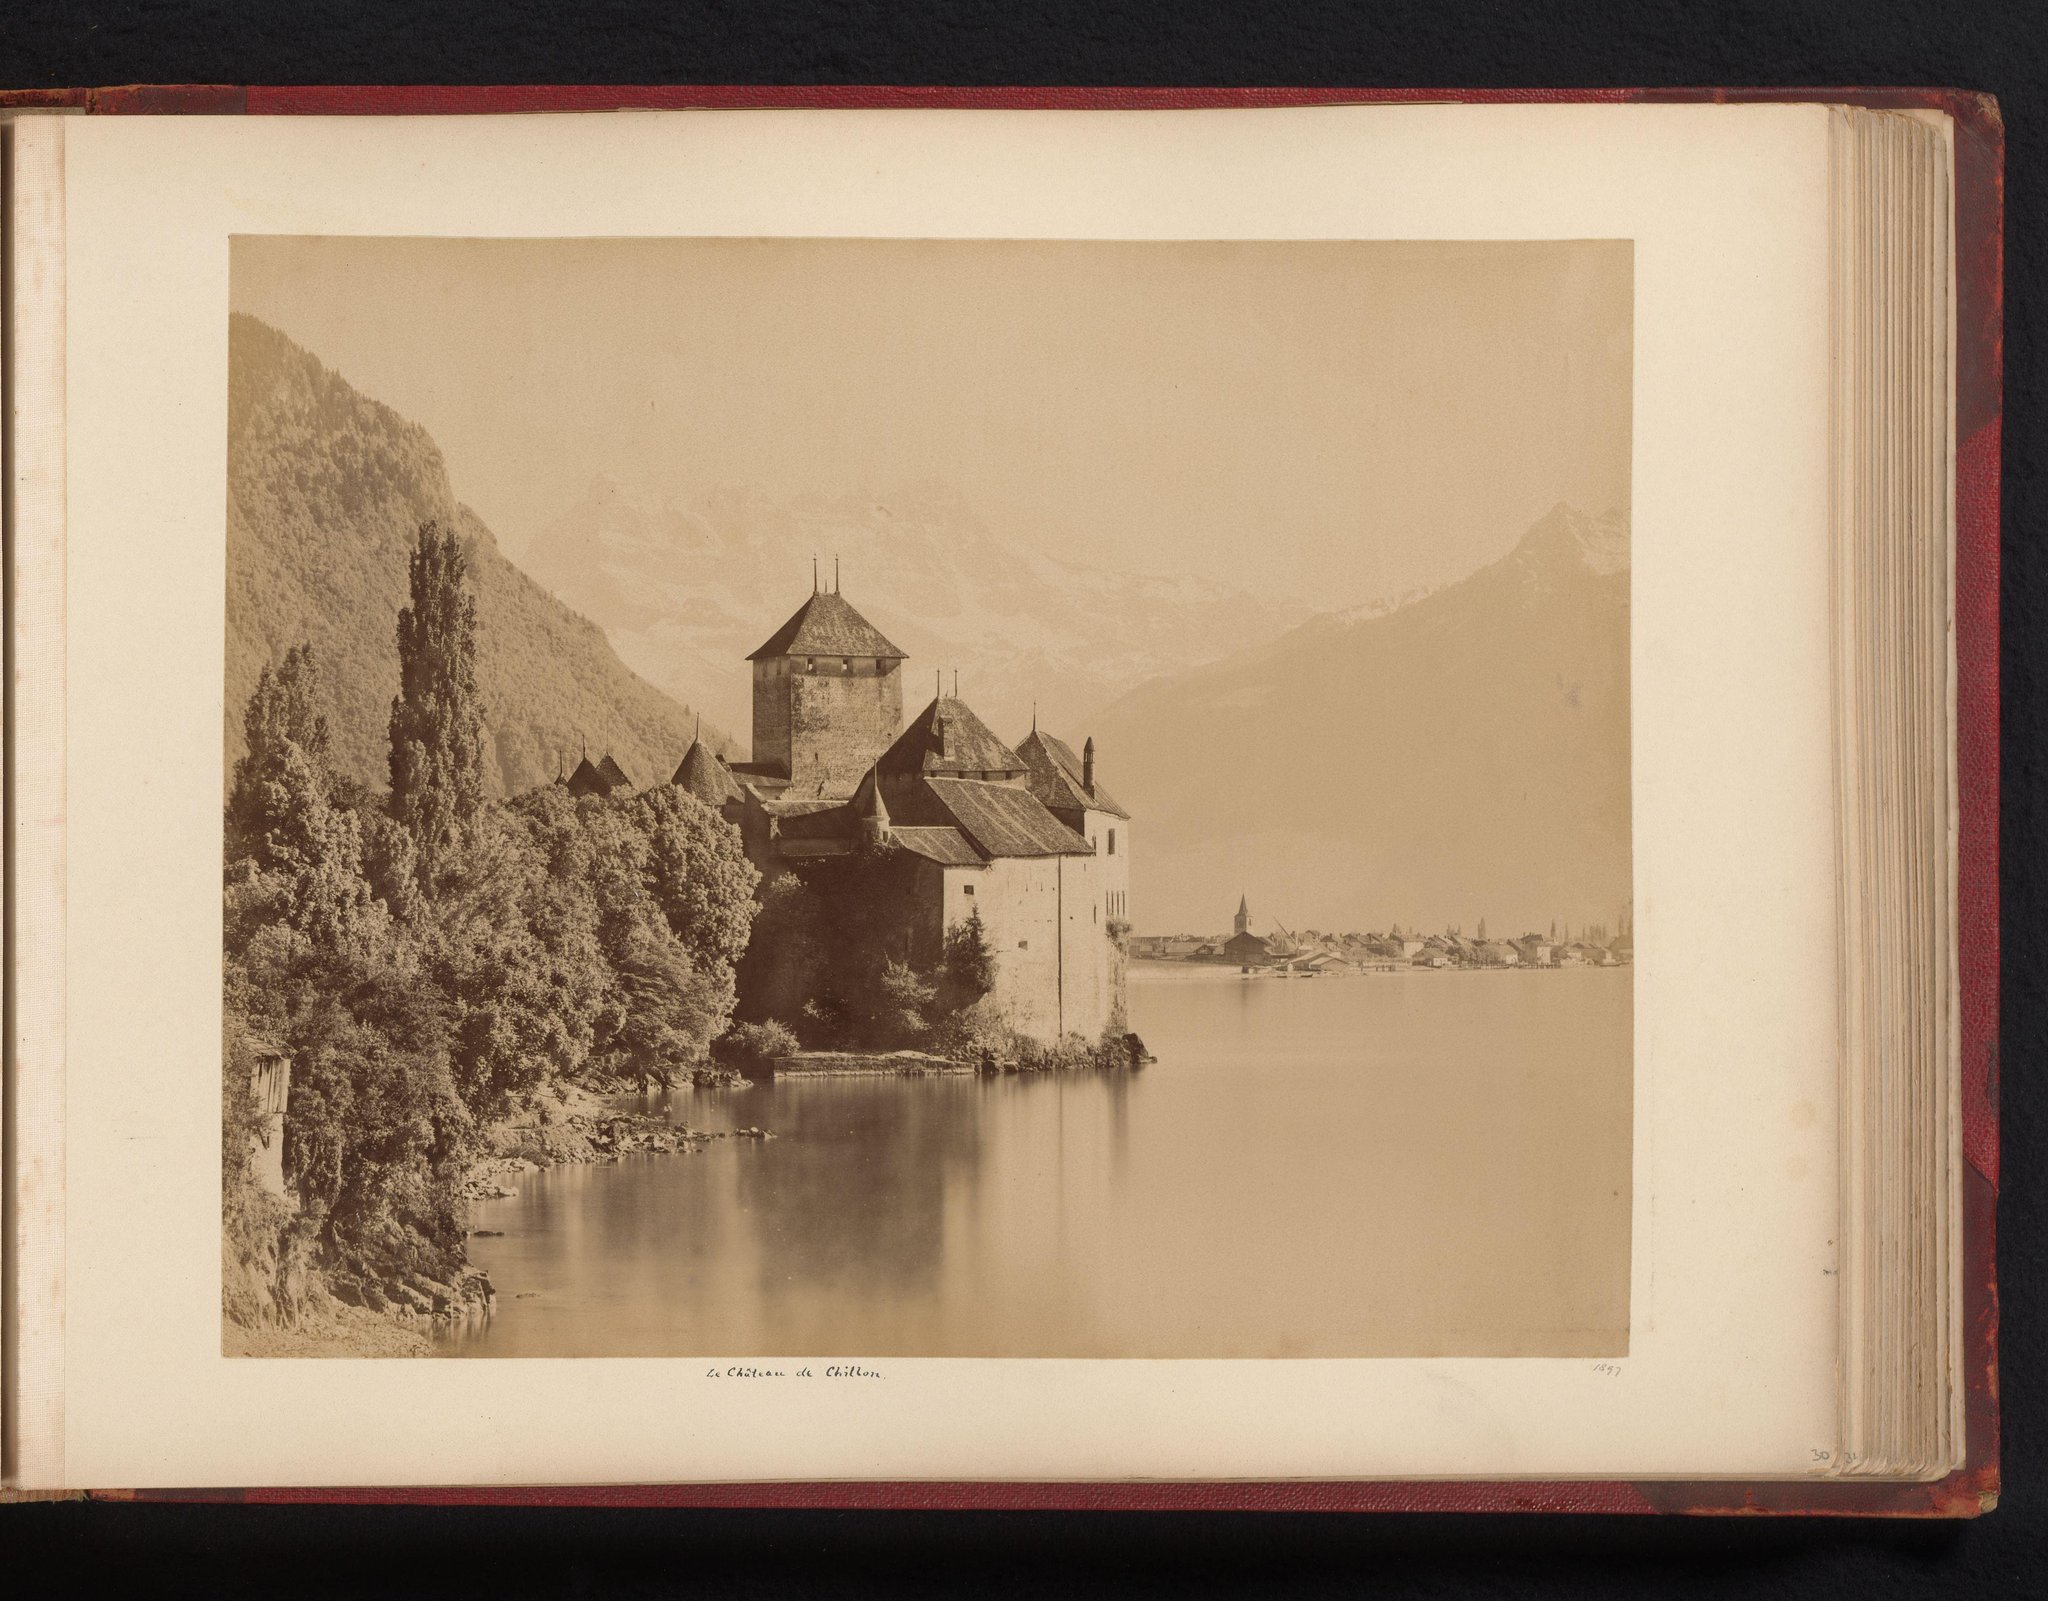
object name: album leaf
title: Gezicht op het kasteel van Chillon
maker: Anonymous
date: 1897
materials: photographic support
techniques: albumen print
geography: vaud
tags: lake, landscape with tower or castle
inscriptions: annotation: ‘Le Château de Chillon 1897’